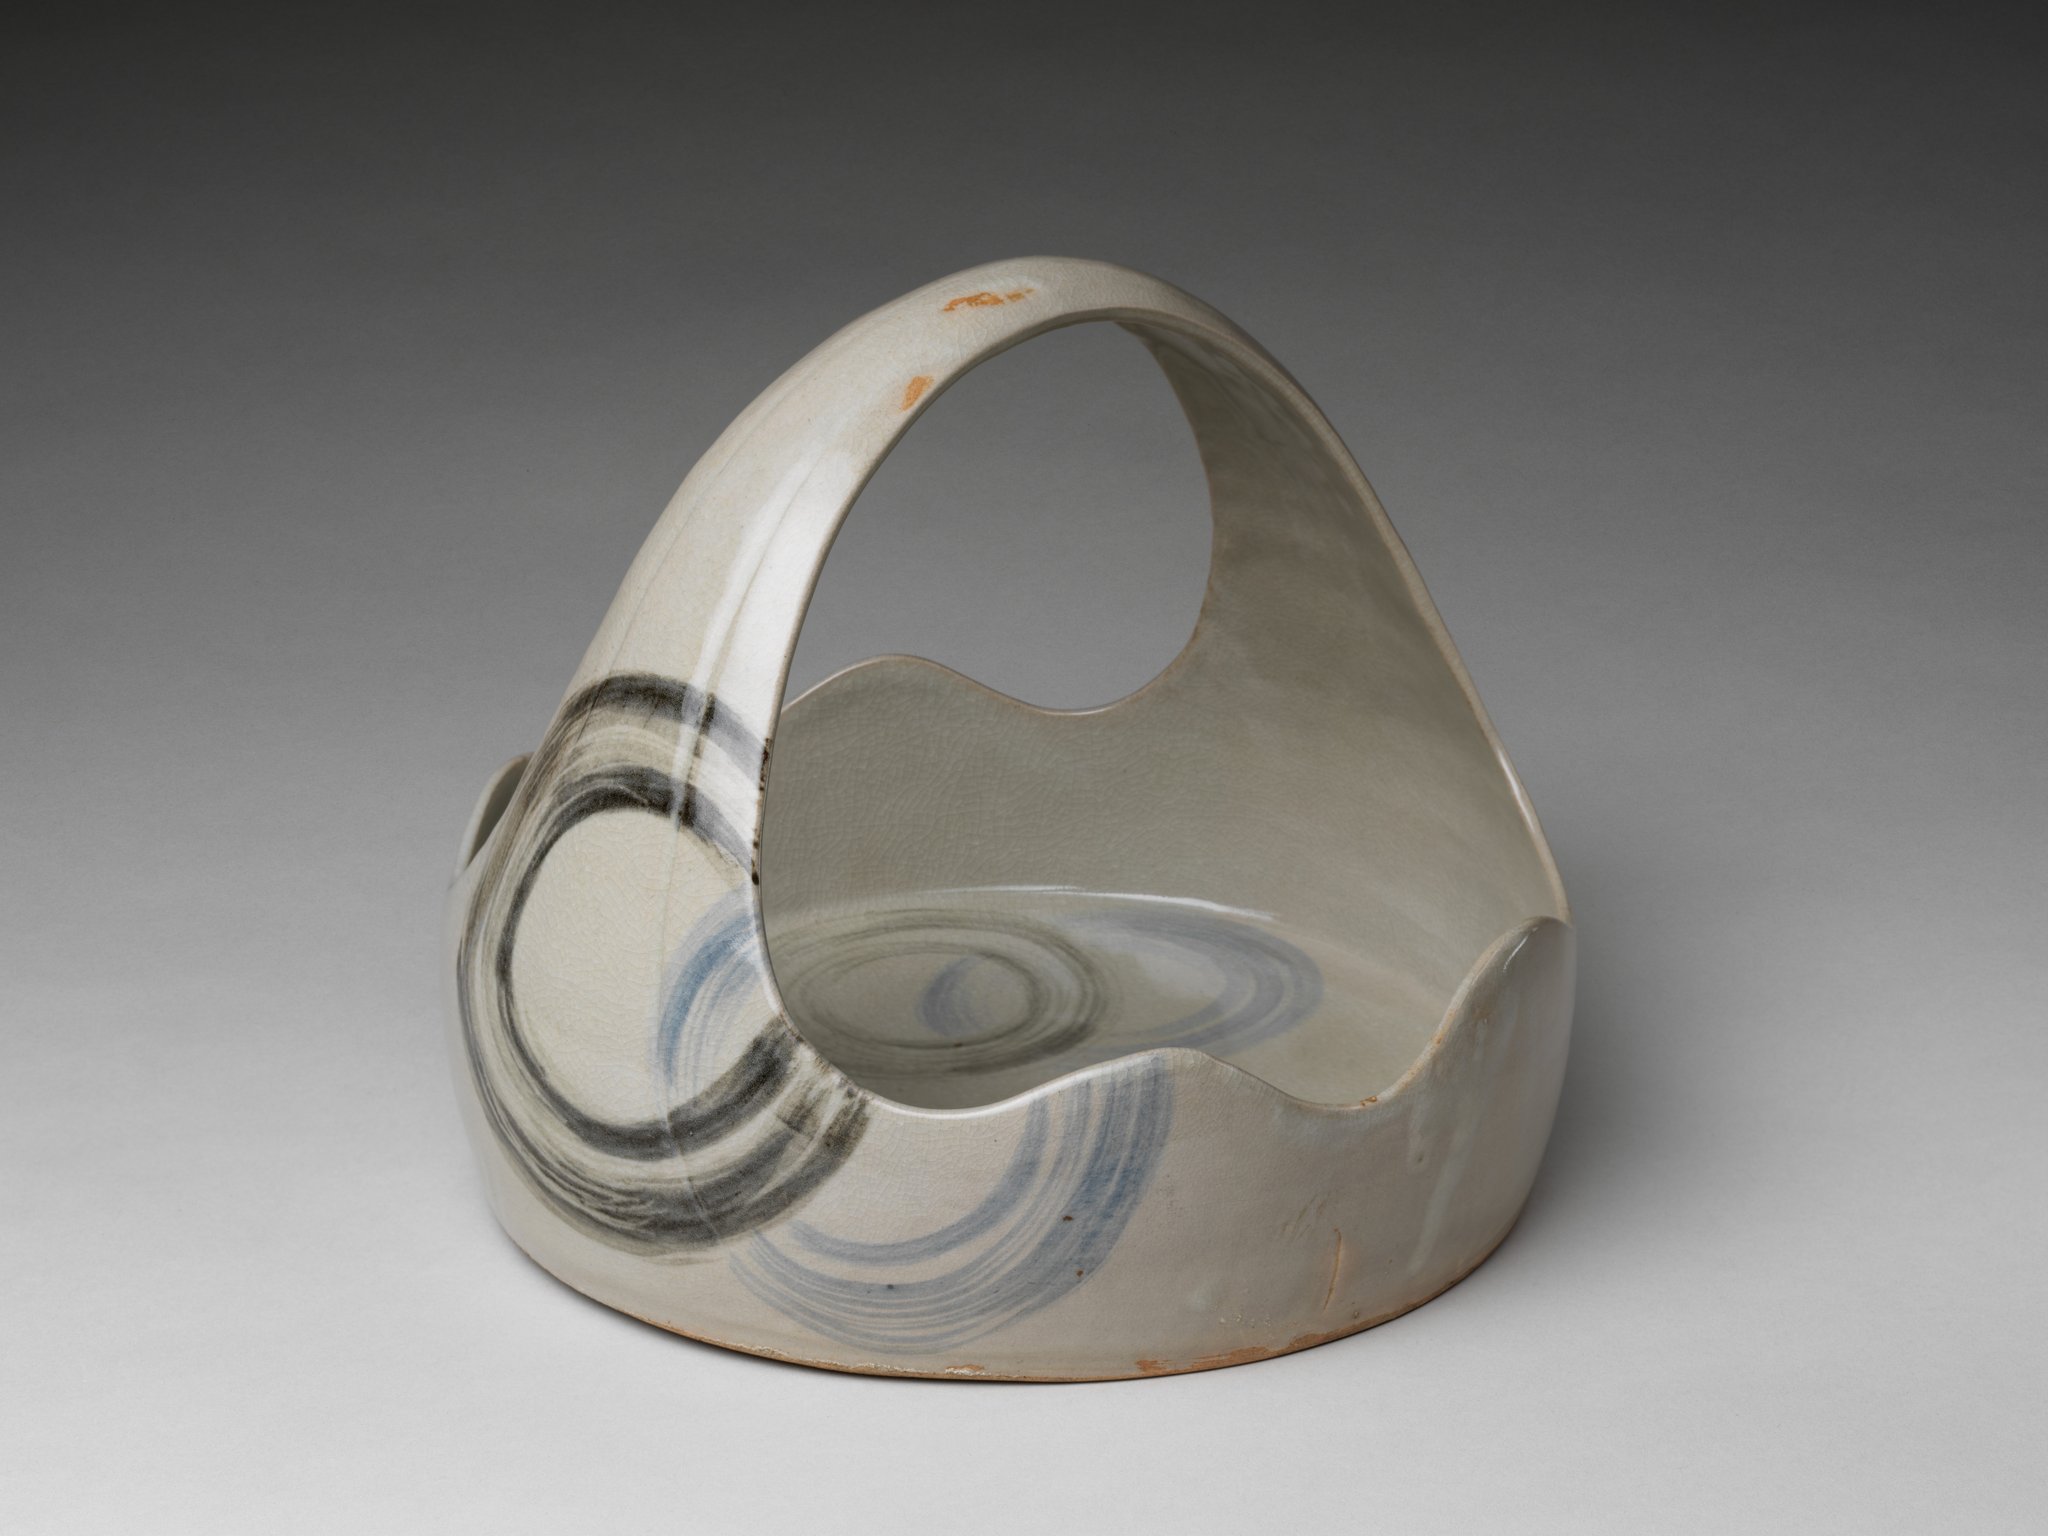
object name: dish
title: Cake dish with handle and design of whirlpools (Tebachi)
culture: japanese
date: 1615-1868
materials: enamel, stoneware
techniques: overglaze